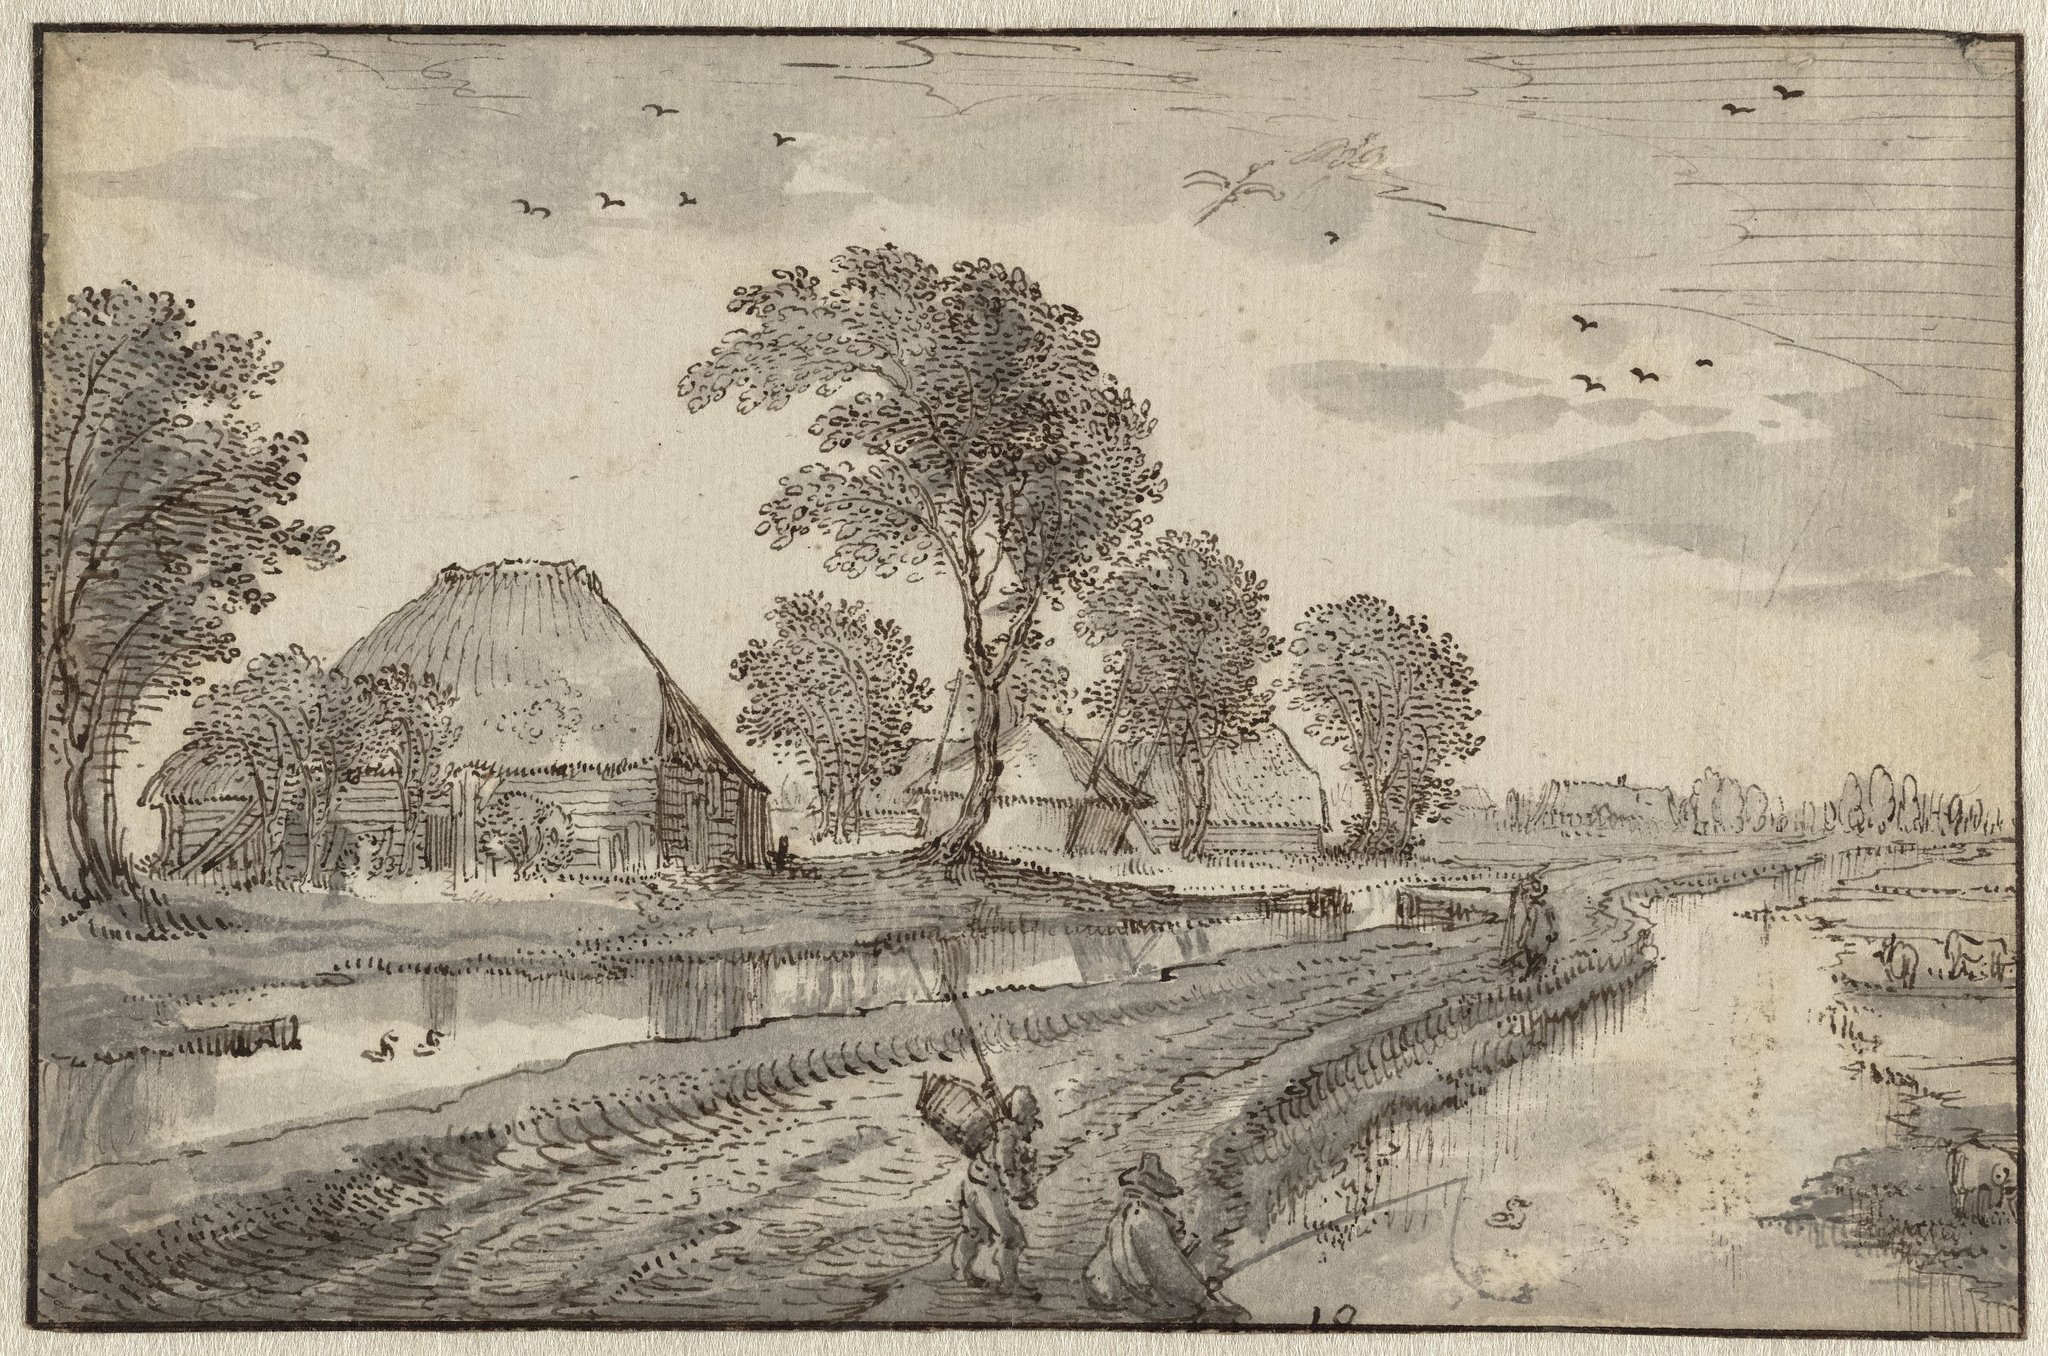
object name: drawing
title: Road between Watercourses in a Polder Landscape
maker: claes jansz. visscher (ii)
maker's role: draughtsman, print maker, publisher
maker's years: 1586-1652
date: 1615-1620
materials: ink, paper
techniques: brush, pen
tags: farm or solitary house in landscape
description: incompleet, drie van de zeven bekende tekeningen in RPK